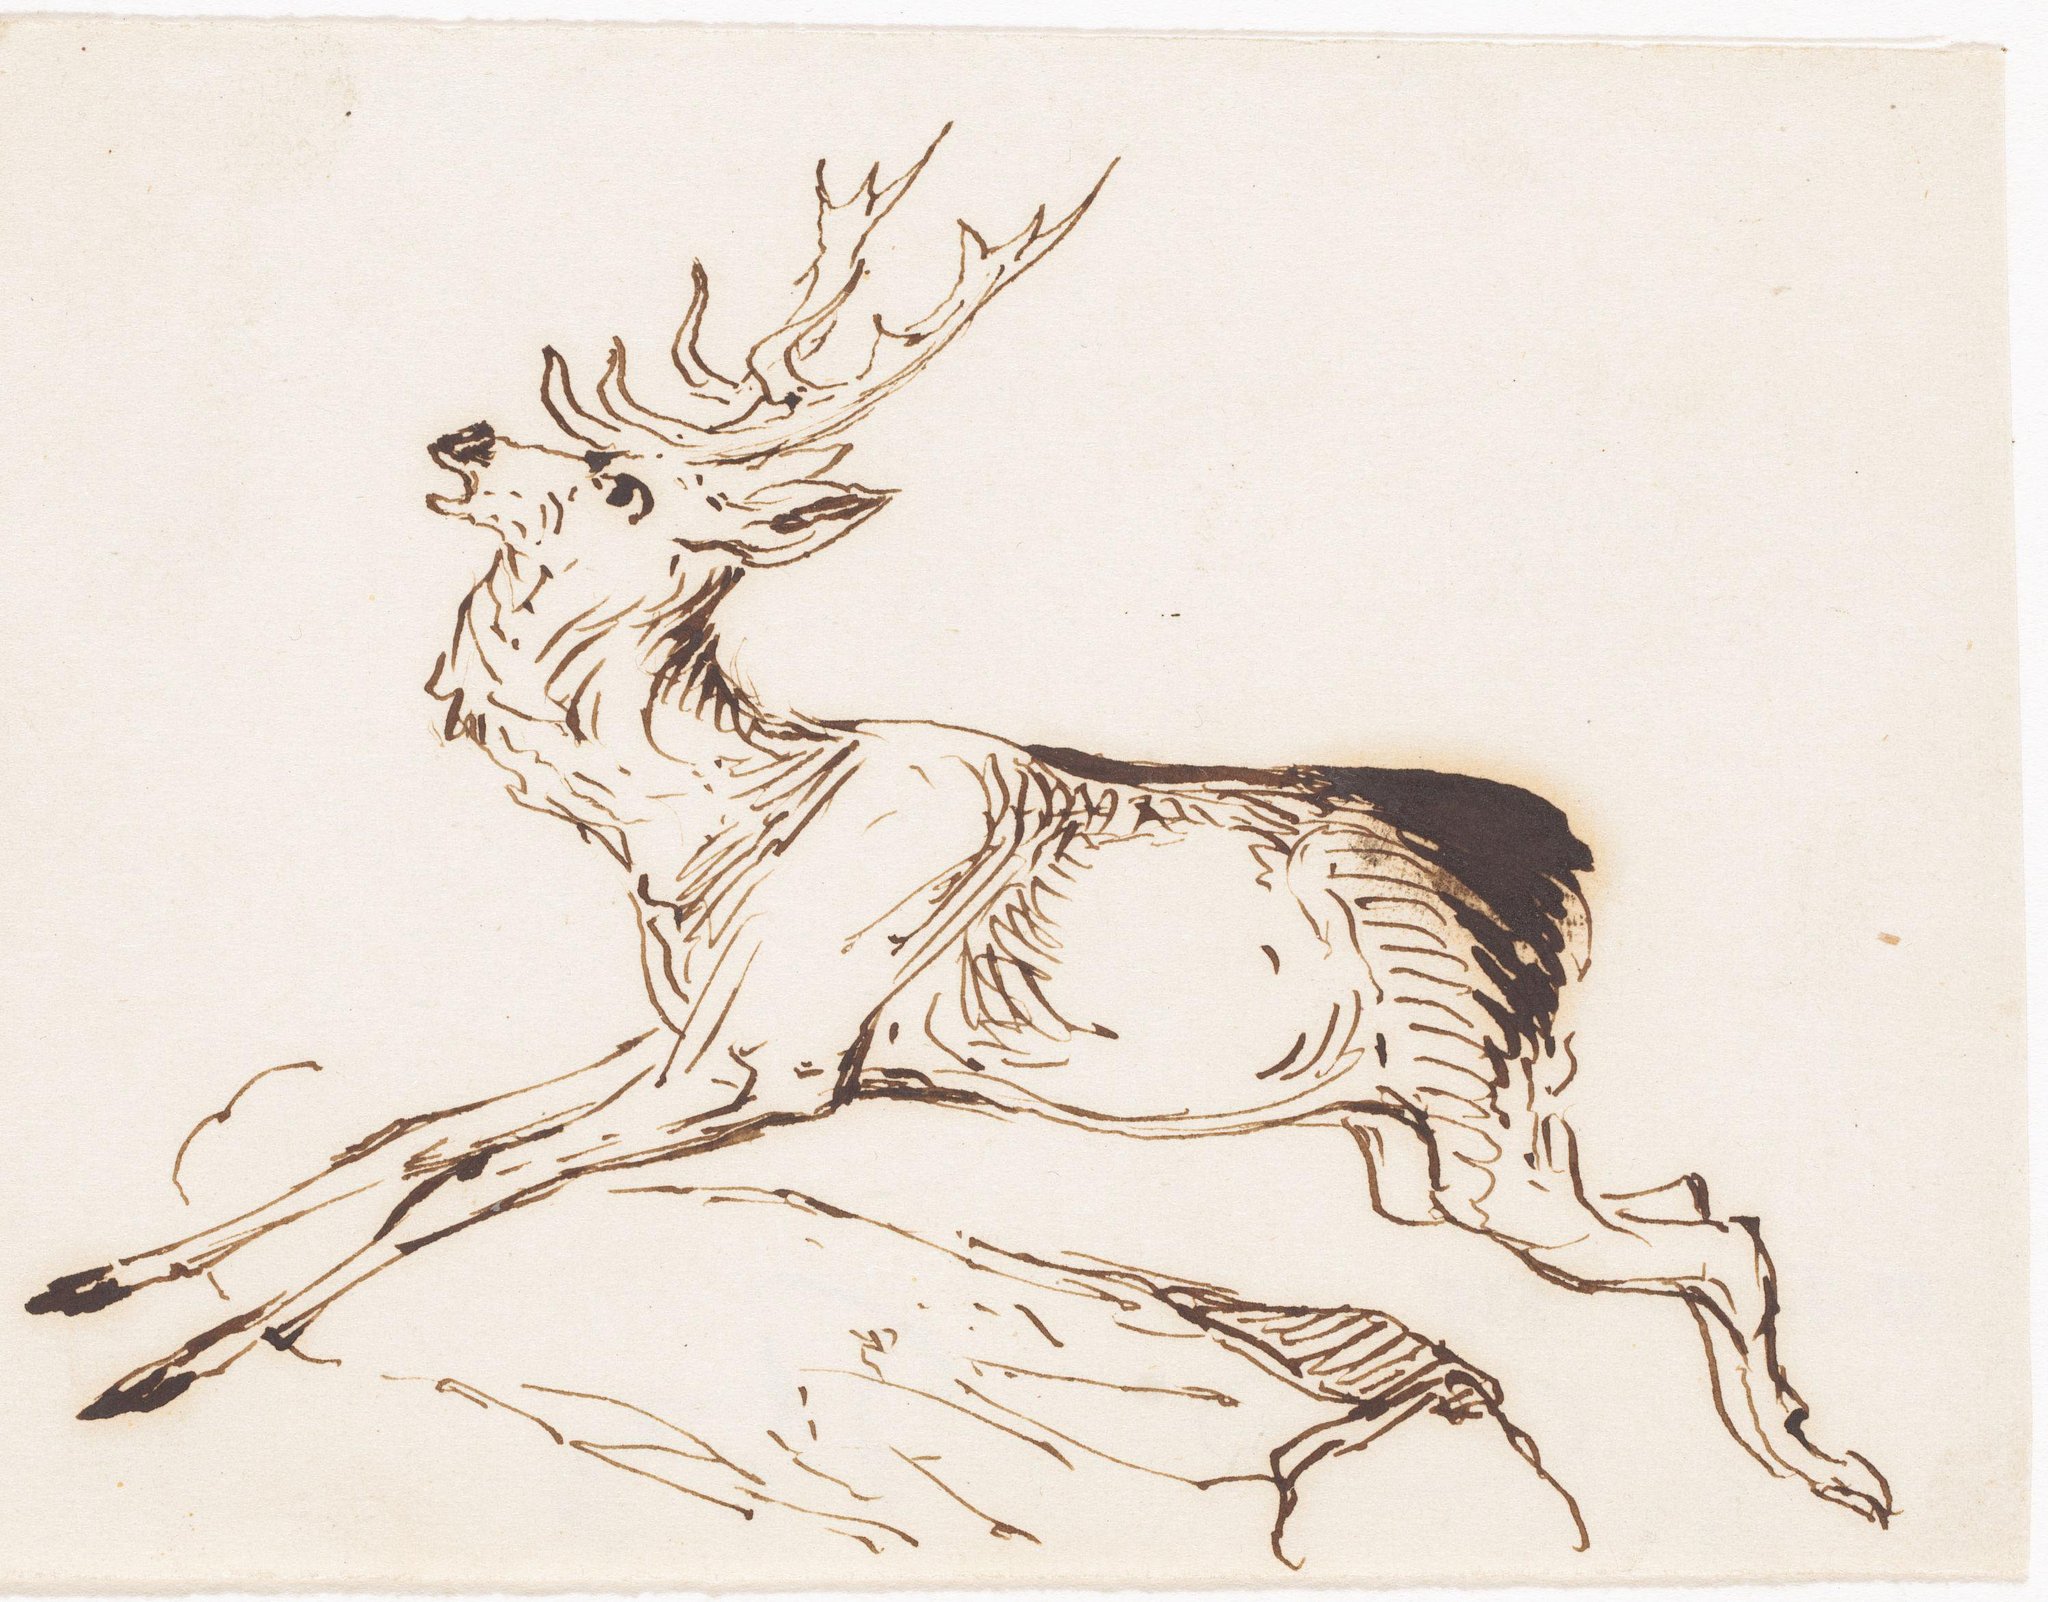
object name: drawing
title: Hert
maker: johannes tavenraat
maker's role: draughtsman, painter, print maker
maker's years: 1809-1881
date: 1840-1880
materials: ink, paper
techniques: pen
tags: hoofed animals: deer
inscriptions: signature: ‘JT’, collector's mark: Lugt 2228